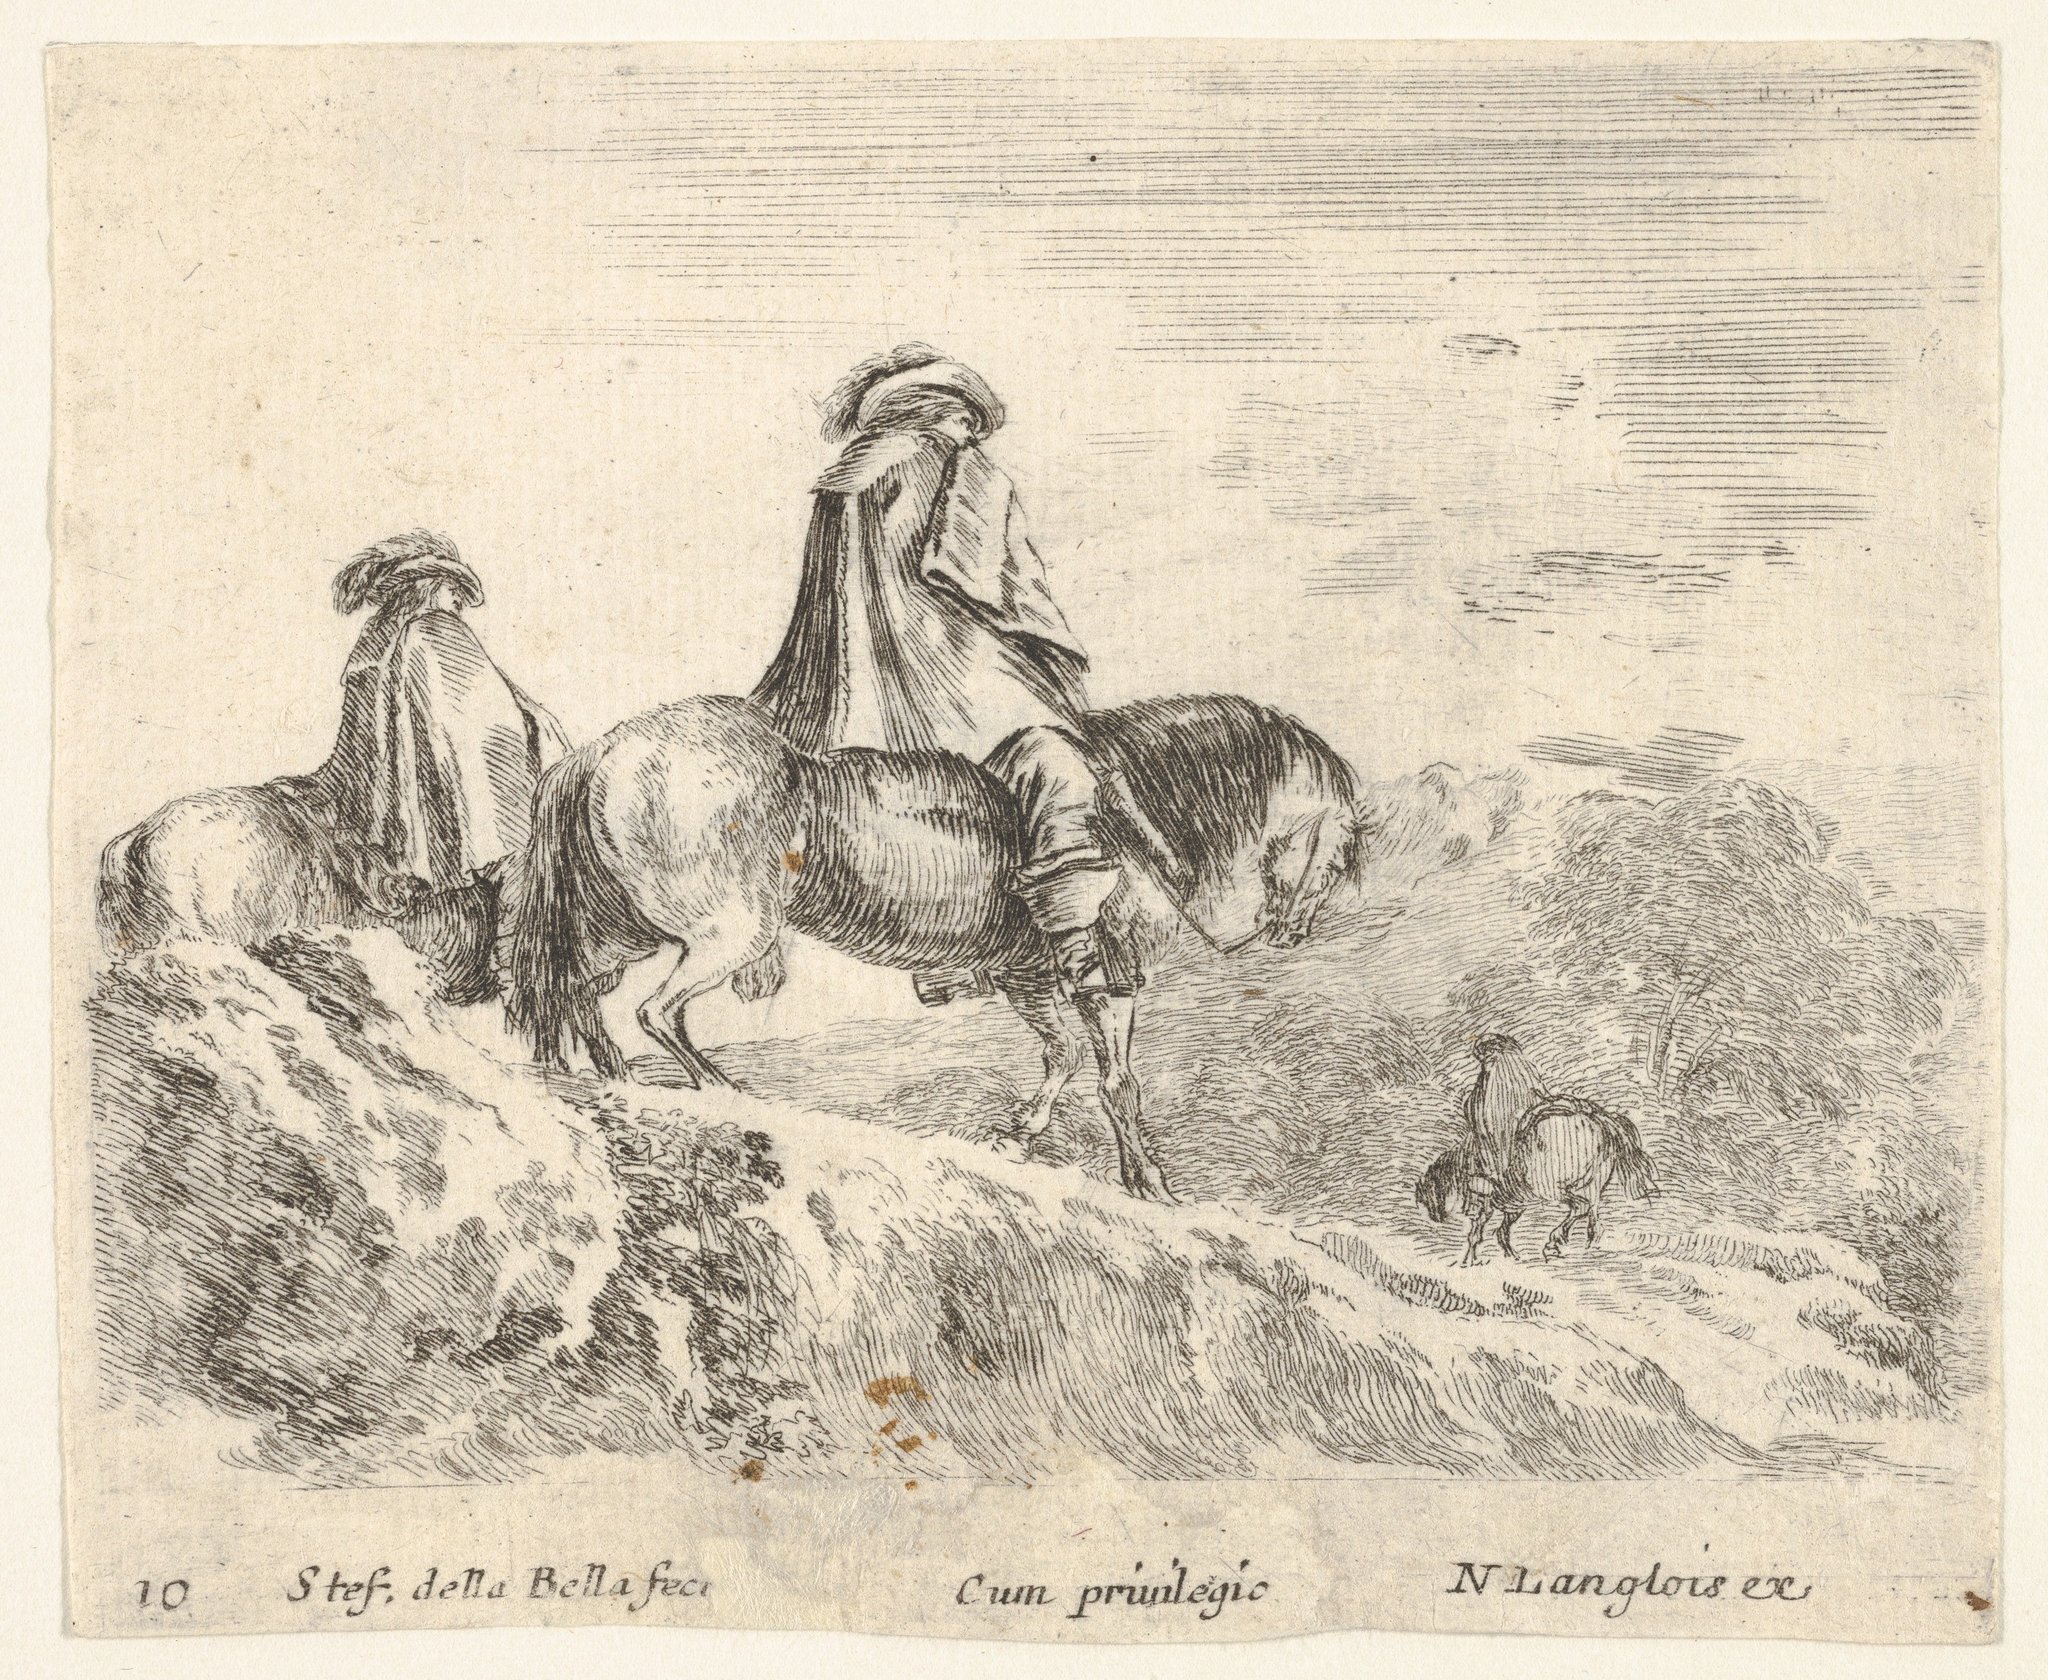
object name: print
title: Plate 10: two horsemen descending a mountain at left, another horseman to right in background, from "Diversi Capricci"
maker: stefano della bella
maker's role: artist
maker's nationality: italian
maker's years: 1610-1664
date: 1644-1647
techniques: etching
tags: men,horses